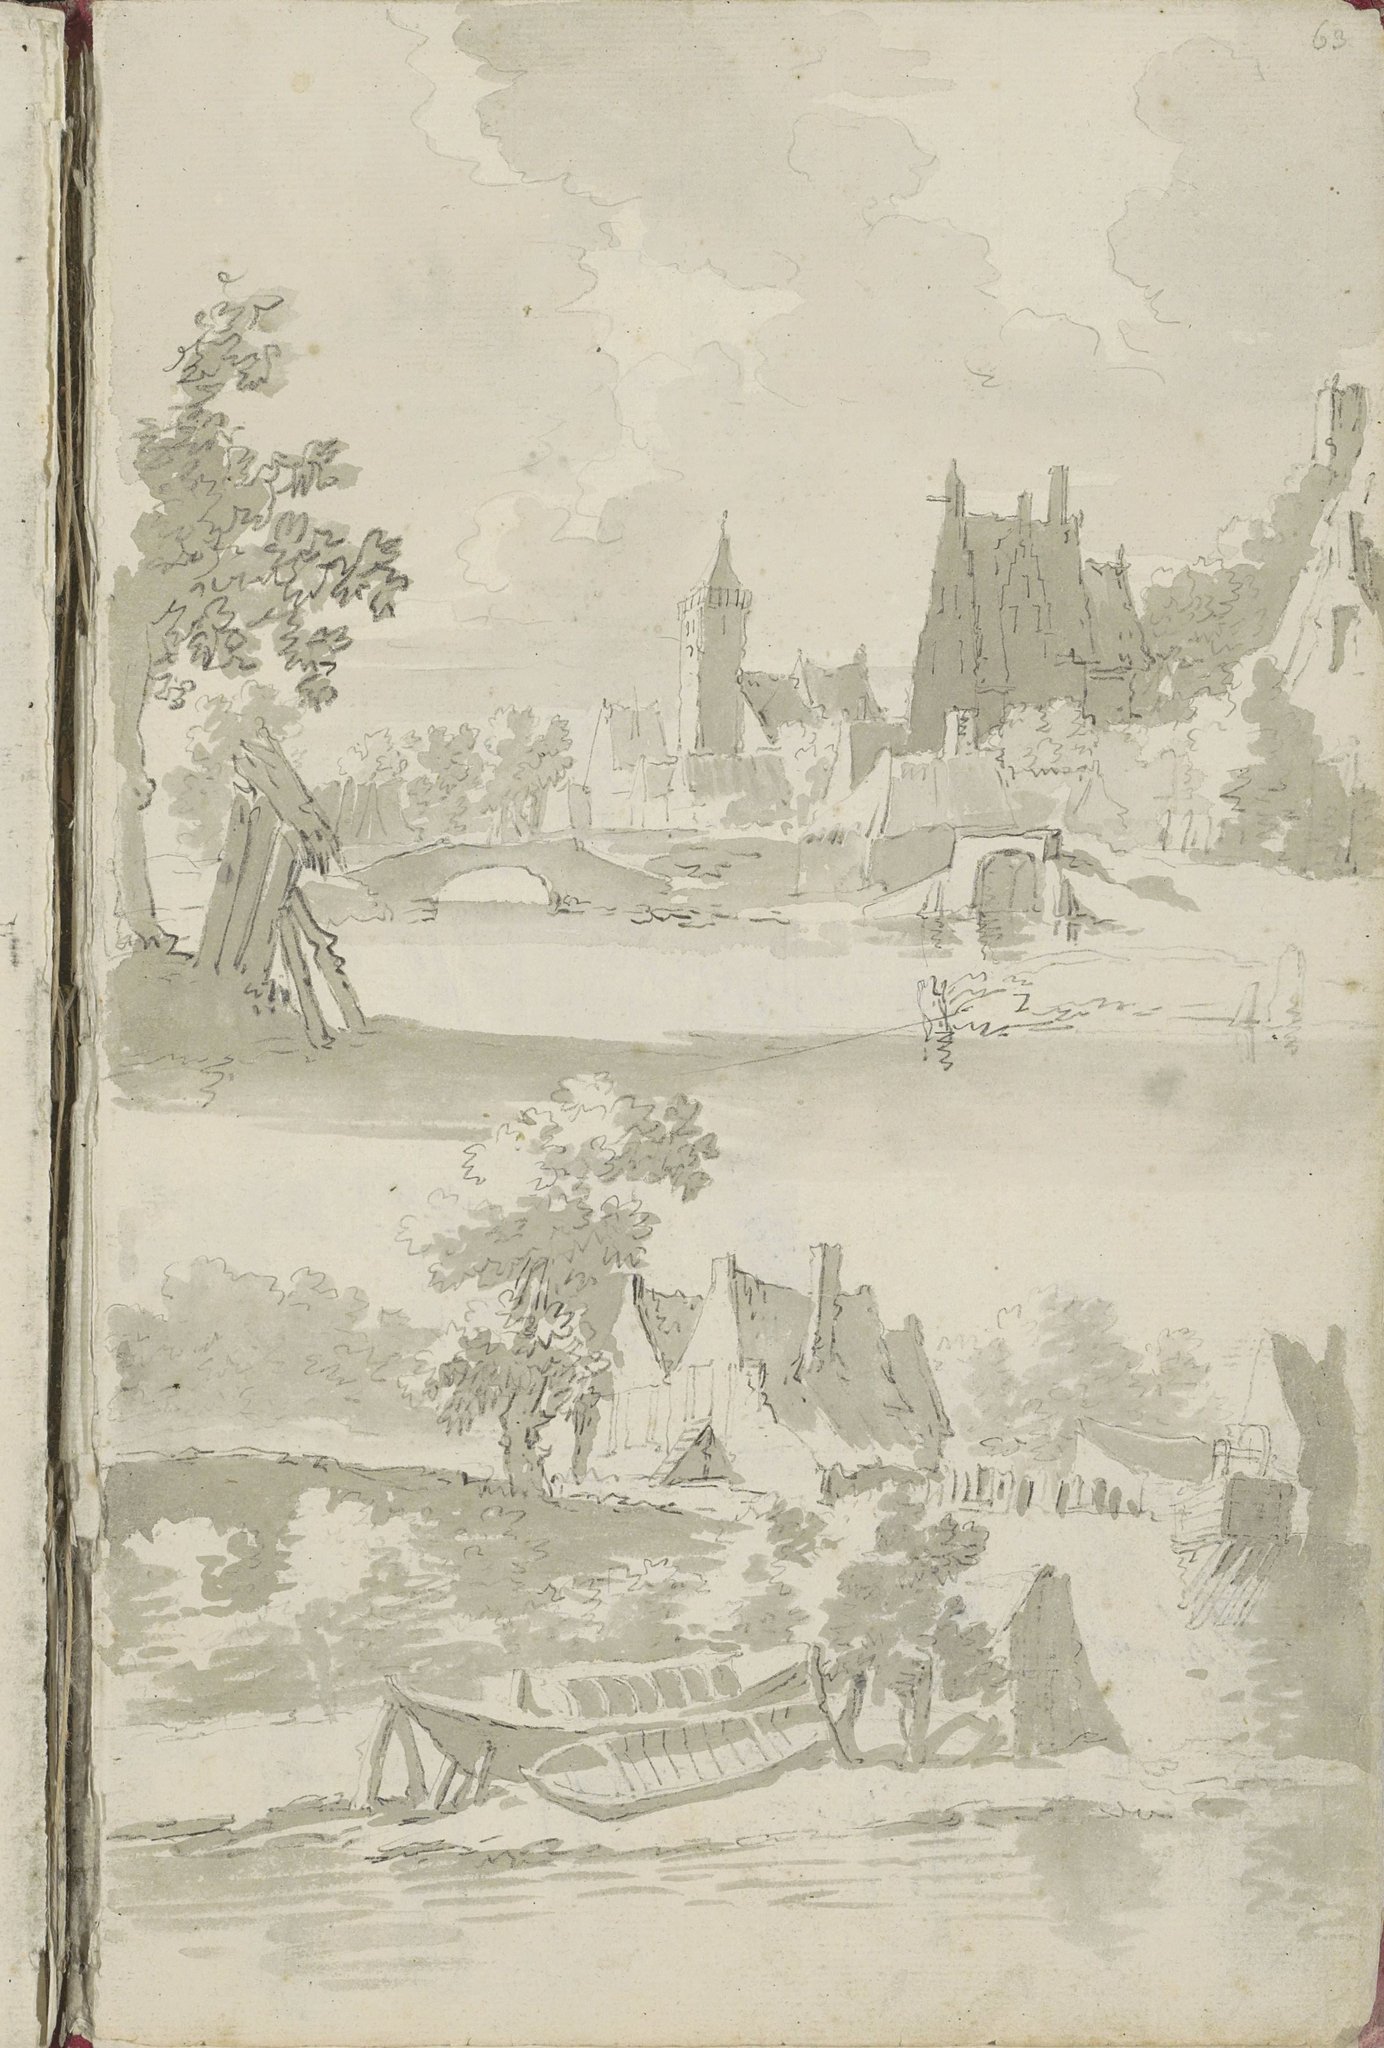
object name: sketchbook leaf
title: Gezicht op een stad aan het water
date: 1780-1800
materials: paper, pencil, watercolor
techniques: brush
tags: city-view, and landscape with man-made constructions, landscapes with waters, waterscapes, seascapes (in the temperate zone), rowing-boat, canoe, etc.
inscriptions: annotation: ‘agt bossen’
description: Tevens een studie van een boot aan een waterkant. Op de achtergrond een gebouw. Blad 25 recto uit een schetsboek met 25 bladen.